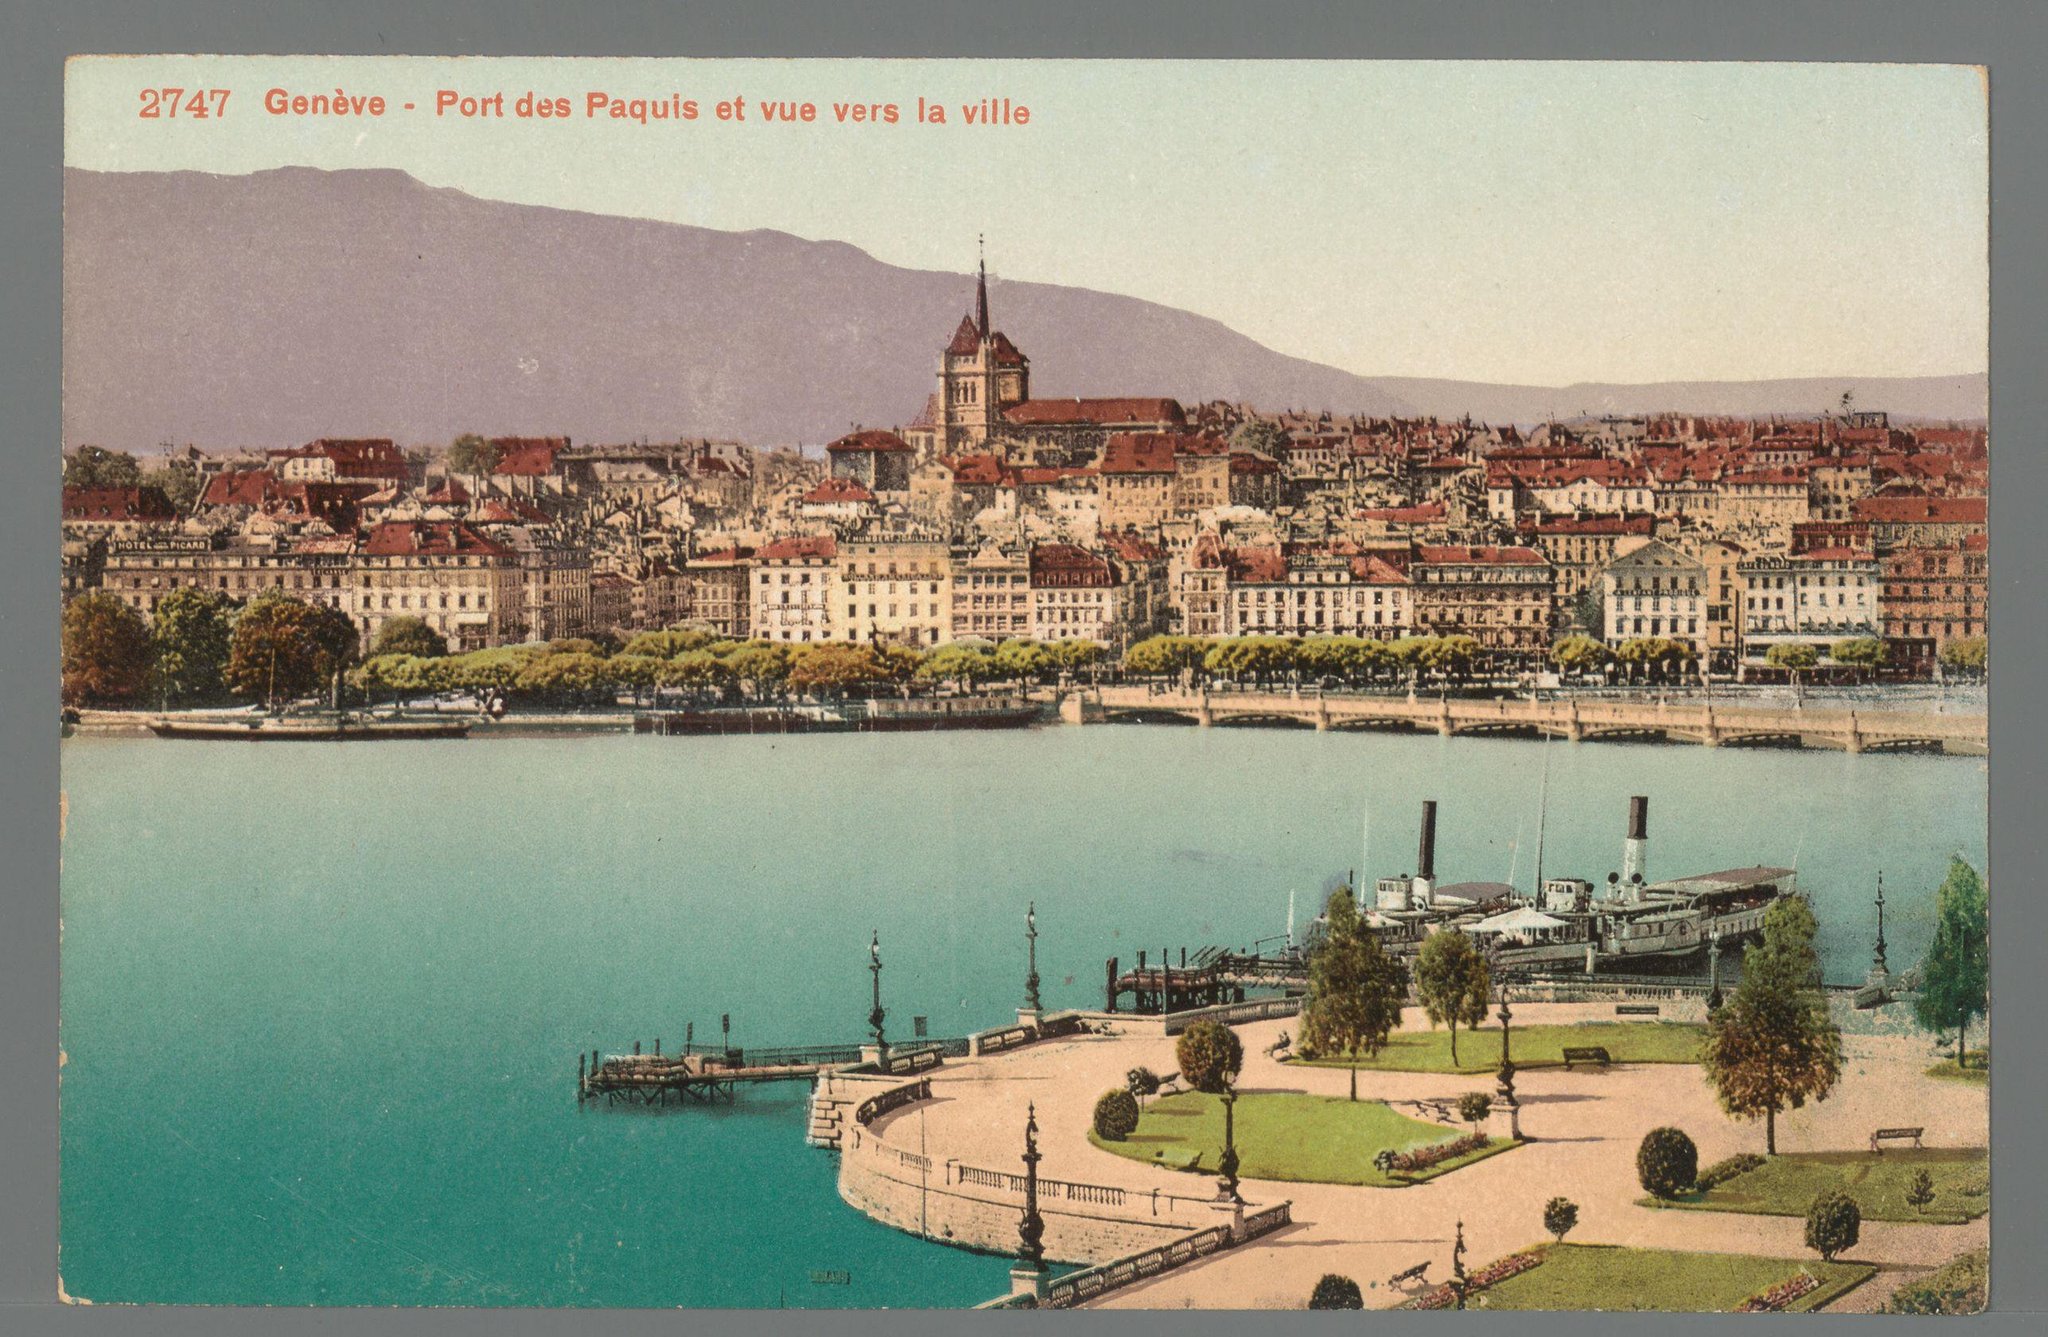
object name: ansichtkaart, prentbriefkaart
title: Genève. Port des Paquis et vue vers la ville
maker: Anonymous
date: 1905-1930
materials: cardboard, photographic process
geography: zurich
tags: lake, public gardens, park, prospect of city, town panorama, silhouette of city